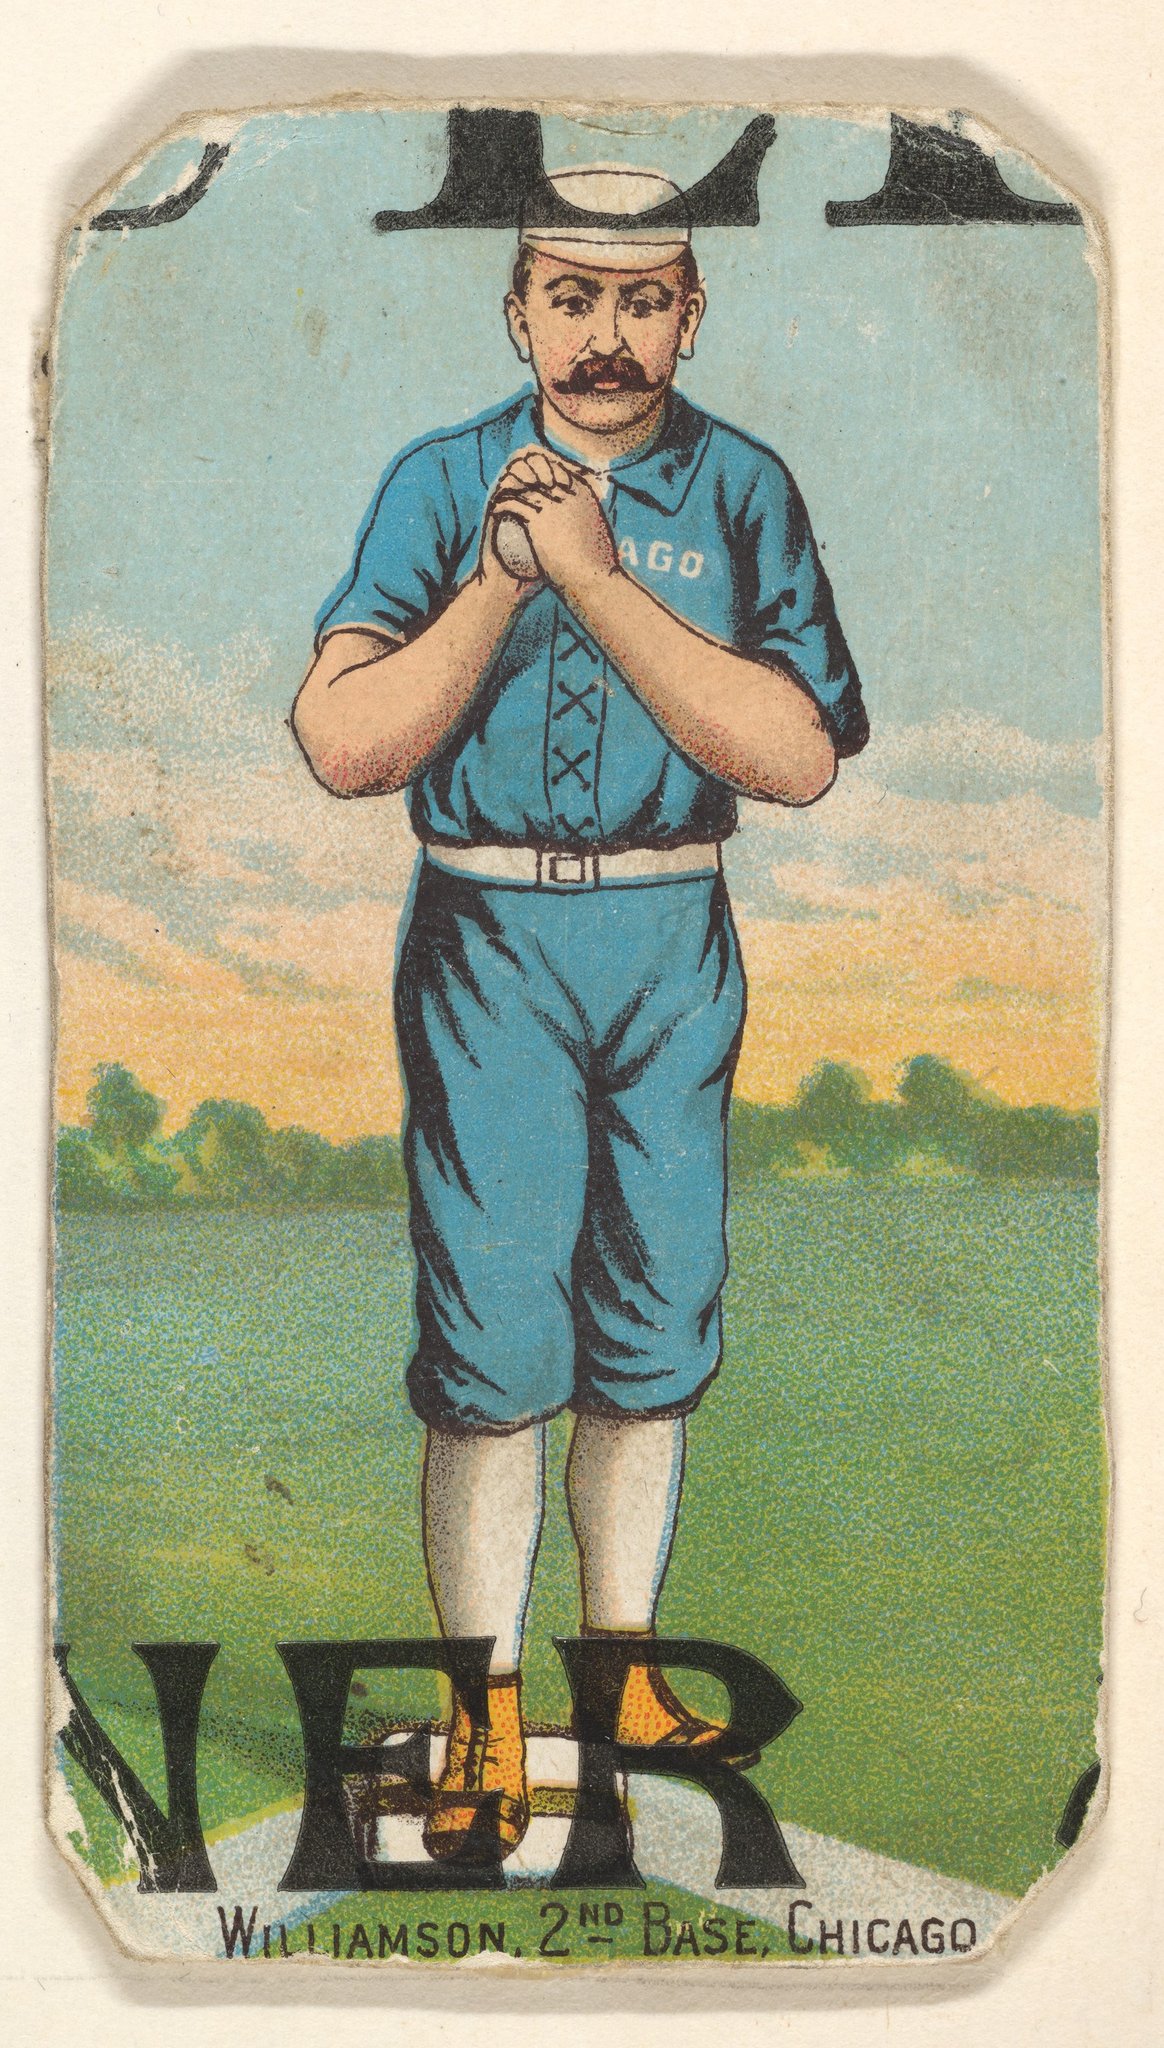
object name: baseball card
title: Williamson, 2nd Base, Chicago, from the Gold Coin series (N284) for Gold Coin Chewing Tobacco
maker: d. buchner & co., new york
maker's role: publisher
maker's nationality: american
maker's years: 1850-1900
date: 1887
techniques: color lithograph, drawing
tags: men,baseball,athletes